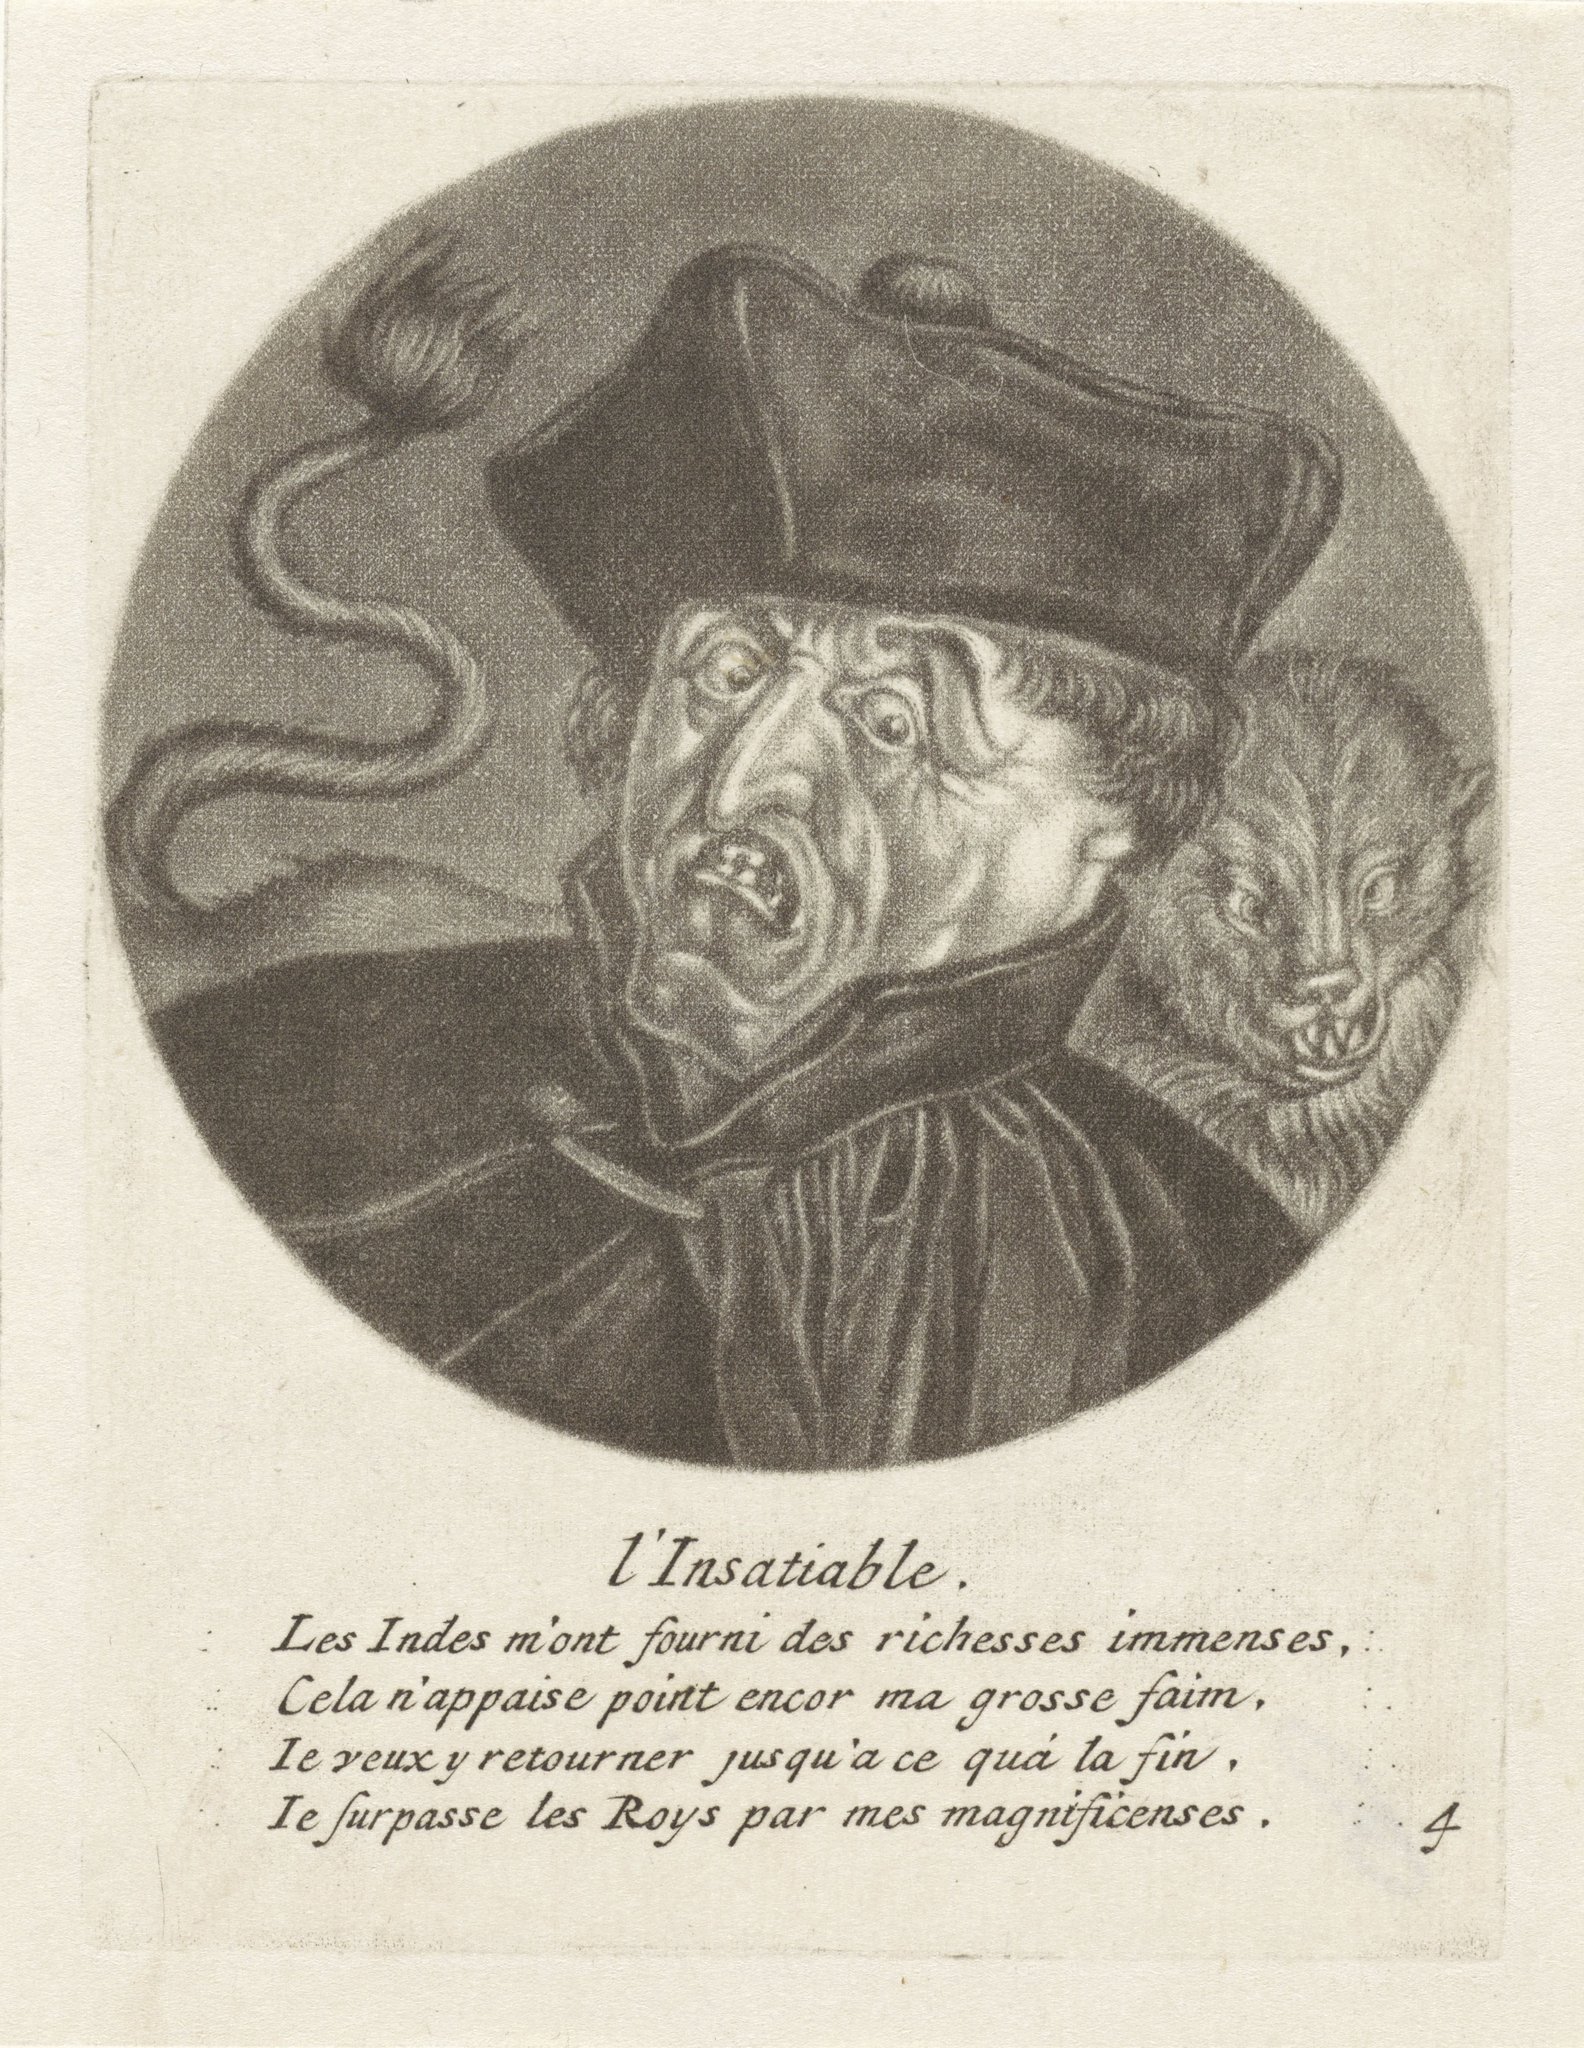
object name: print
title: l'Insatiable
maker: jacob gole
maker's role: print maker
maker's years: 1660-1724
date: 1670-1724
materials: paper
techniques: engraving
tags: monk(s), friar(s), beasts of prey, predatory animals, political caricatures and satires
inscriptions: collector's mark: Lugt 2228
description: De prent verscheen in de bundel "Renversement de la Morale Chrétienne par les désordres du Monachisme". Volgens Wiebke Schmoldt (1997) verscheen deze bundel tussen 1693 en 1700.